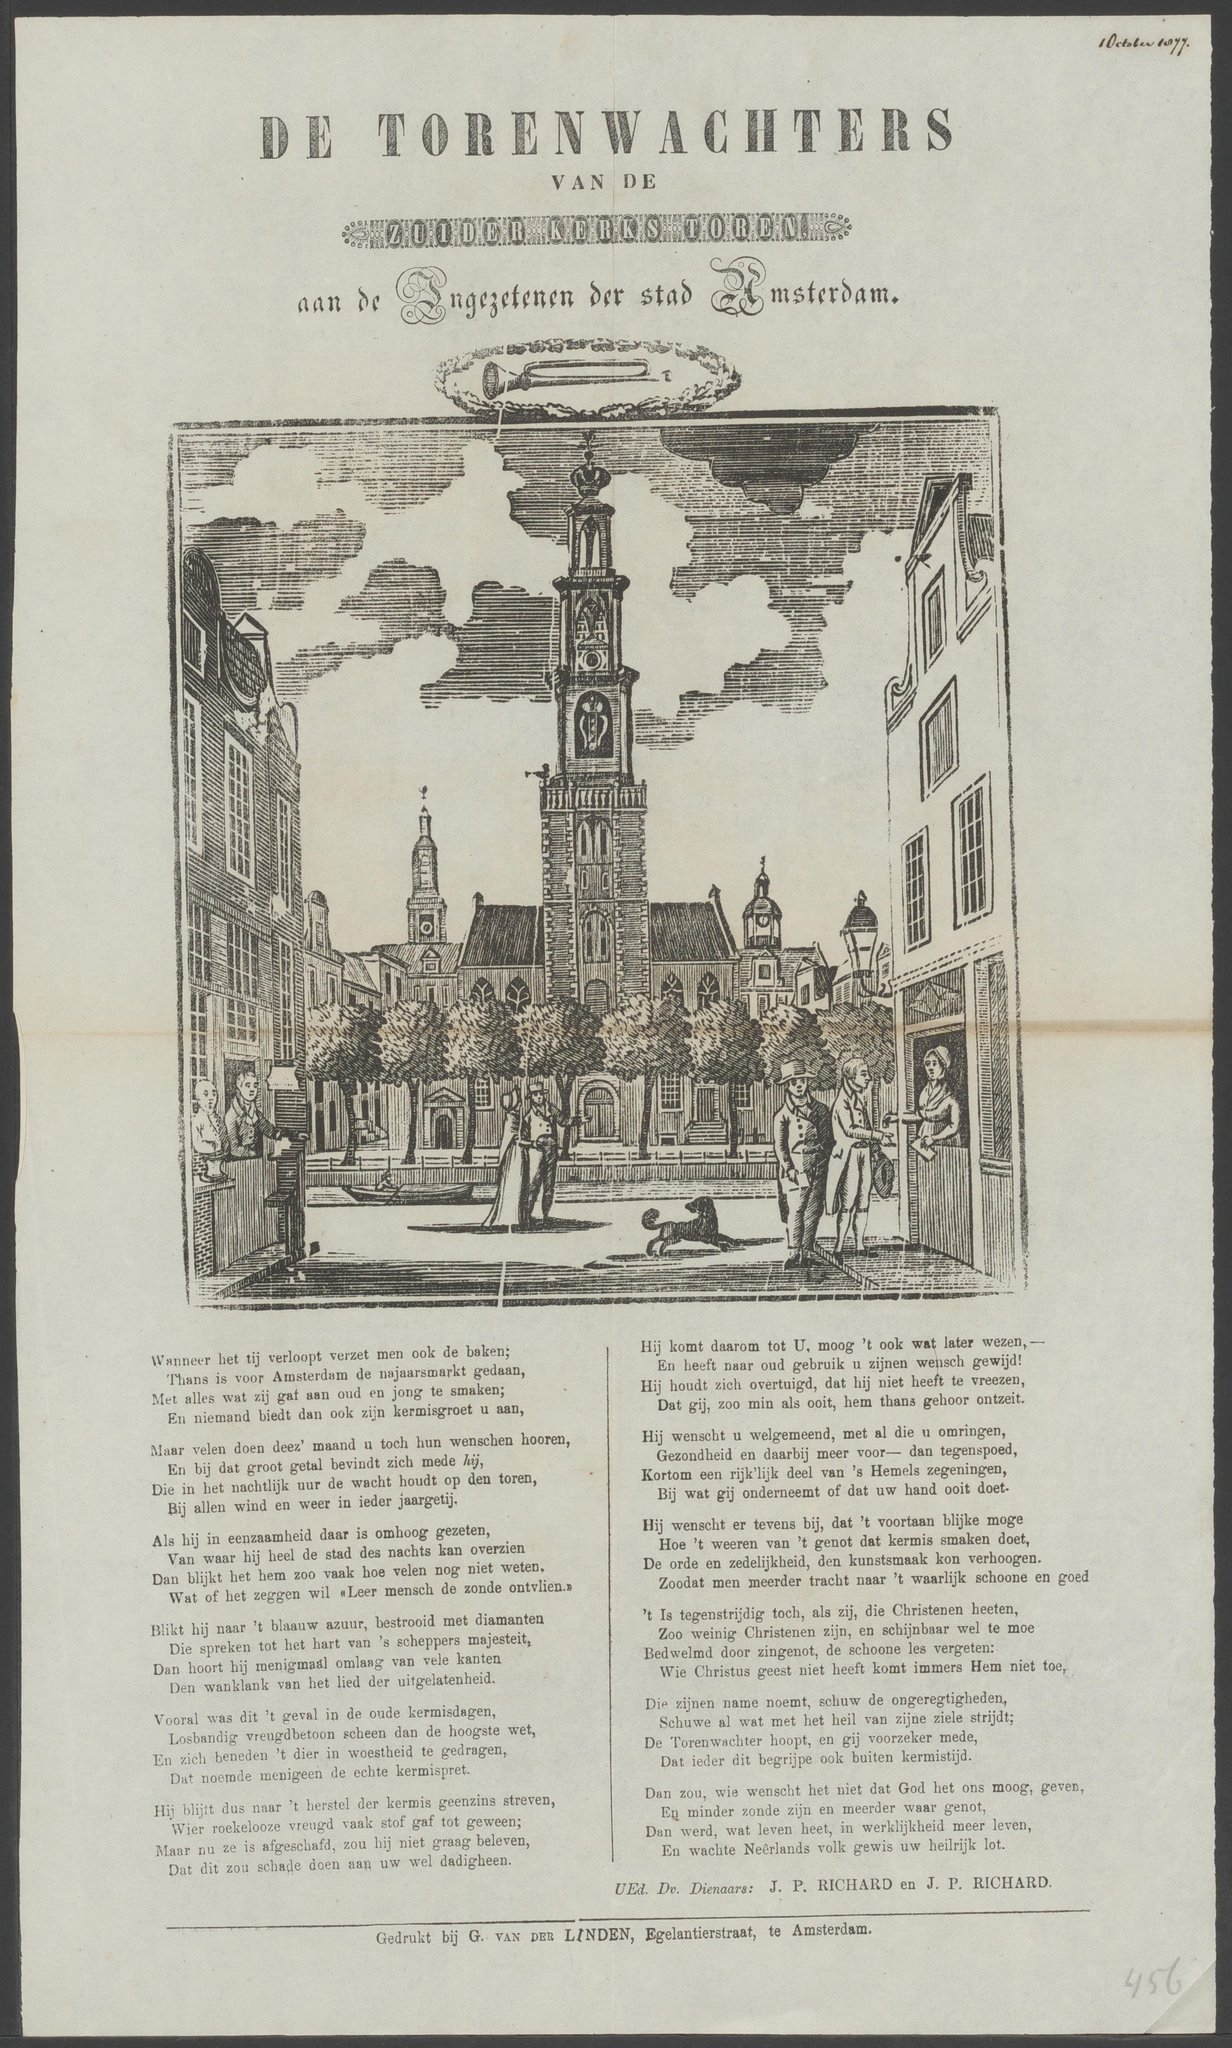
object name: print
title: Kermiswens van de torenwachters van de stad Amsterdam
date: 1860-1875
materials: paper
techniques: letterpress printing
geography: amsterdam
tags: night patrol, tower (of house or building)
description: Kermiswens van de torenwachters van de stad Amsterdam. Bovenaan een trompet met daaronder een een toren in de stad Amterdam met een torenwachter. Onderaan een vers in twee kolommen en een toezang in drie kolommen. Aangeboden door de torenwachters van de toren van de Zuiderkerk: J.P. Richard en J.P. Richard. Onderwerpsrubrieken binnen de Atlas Zeden en Gewoonten: Zeden en gewoonten in engeren zin, Volksleven, Volksbladen, Nieuwjaars- en Kerstwenschen, Amsterdam.